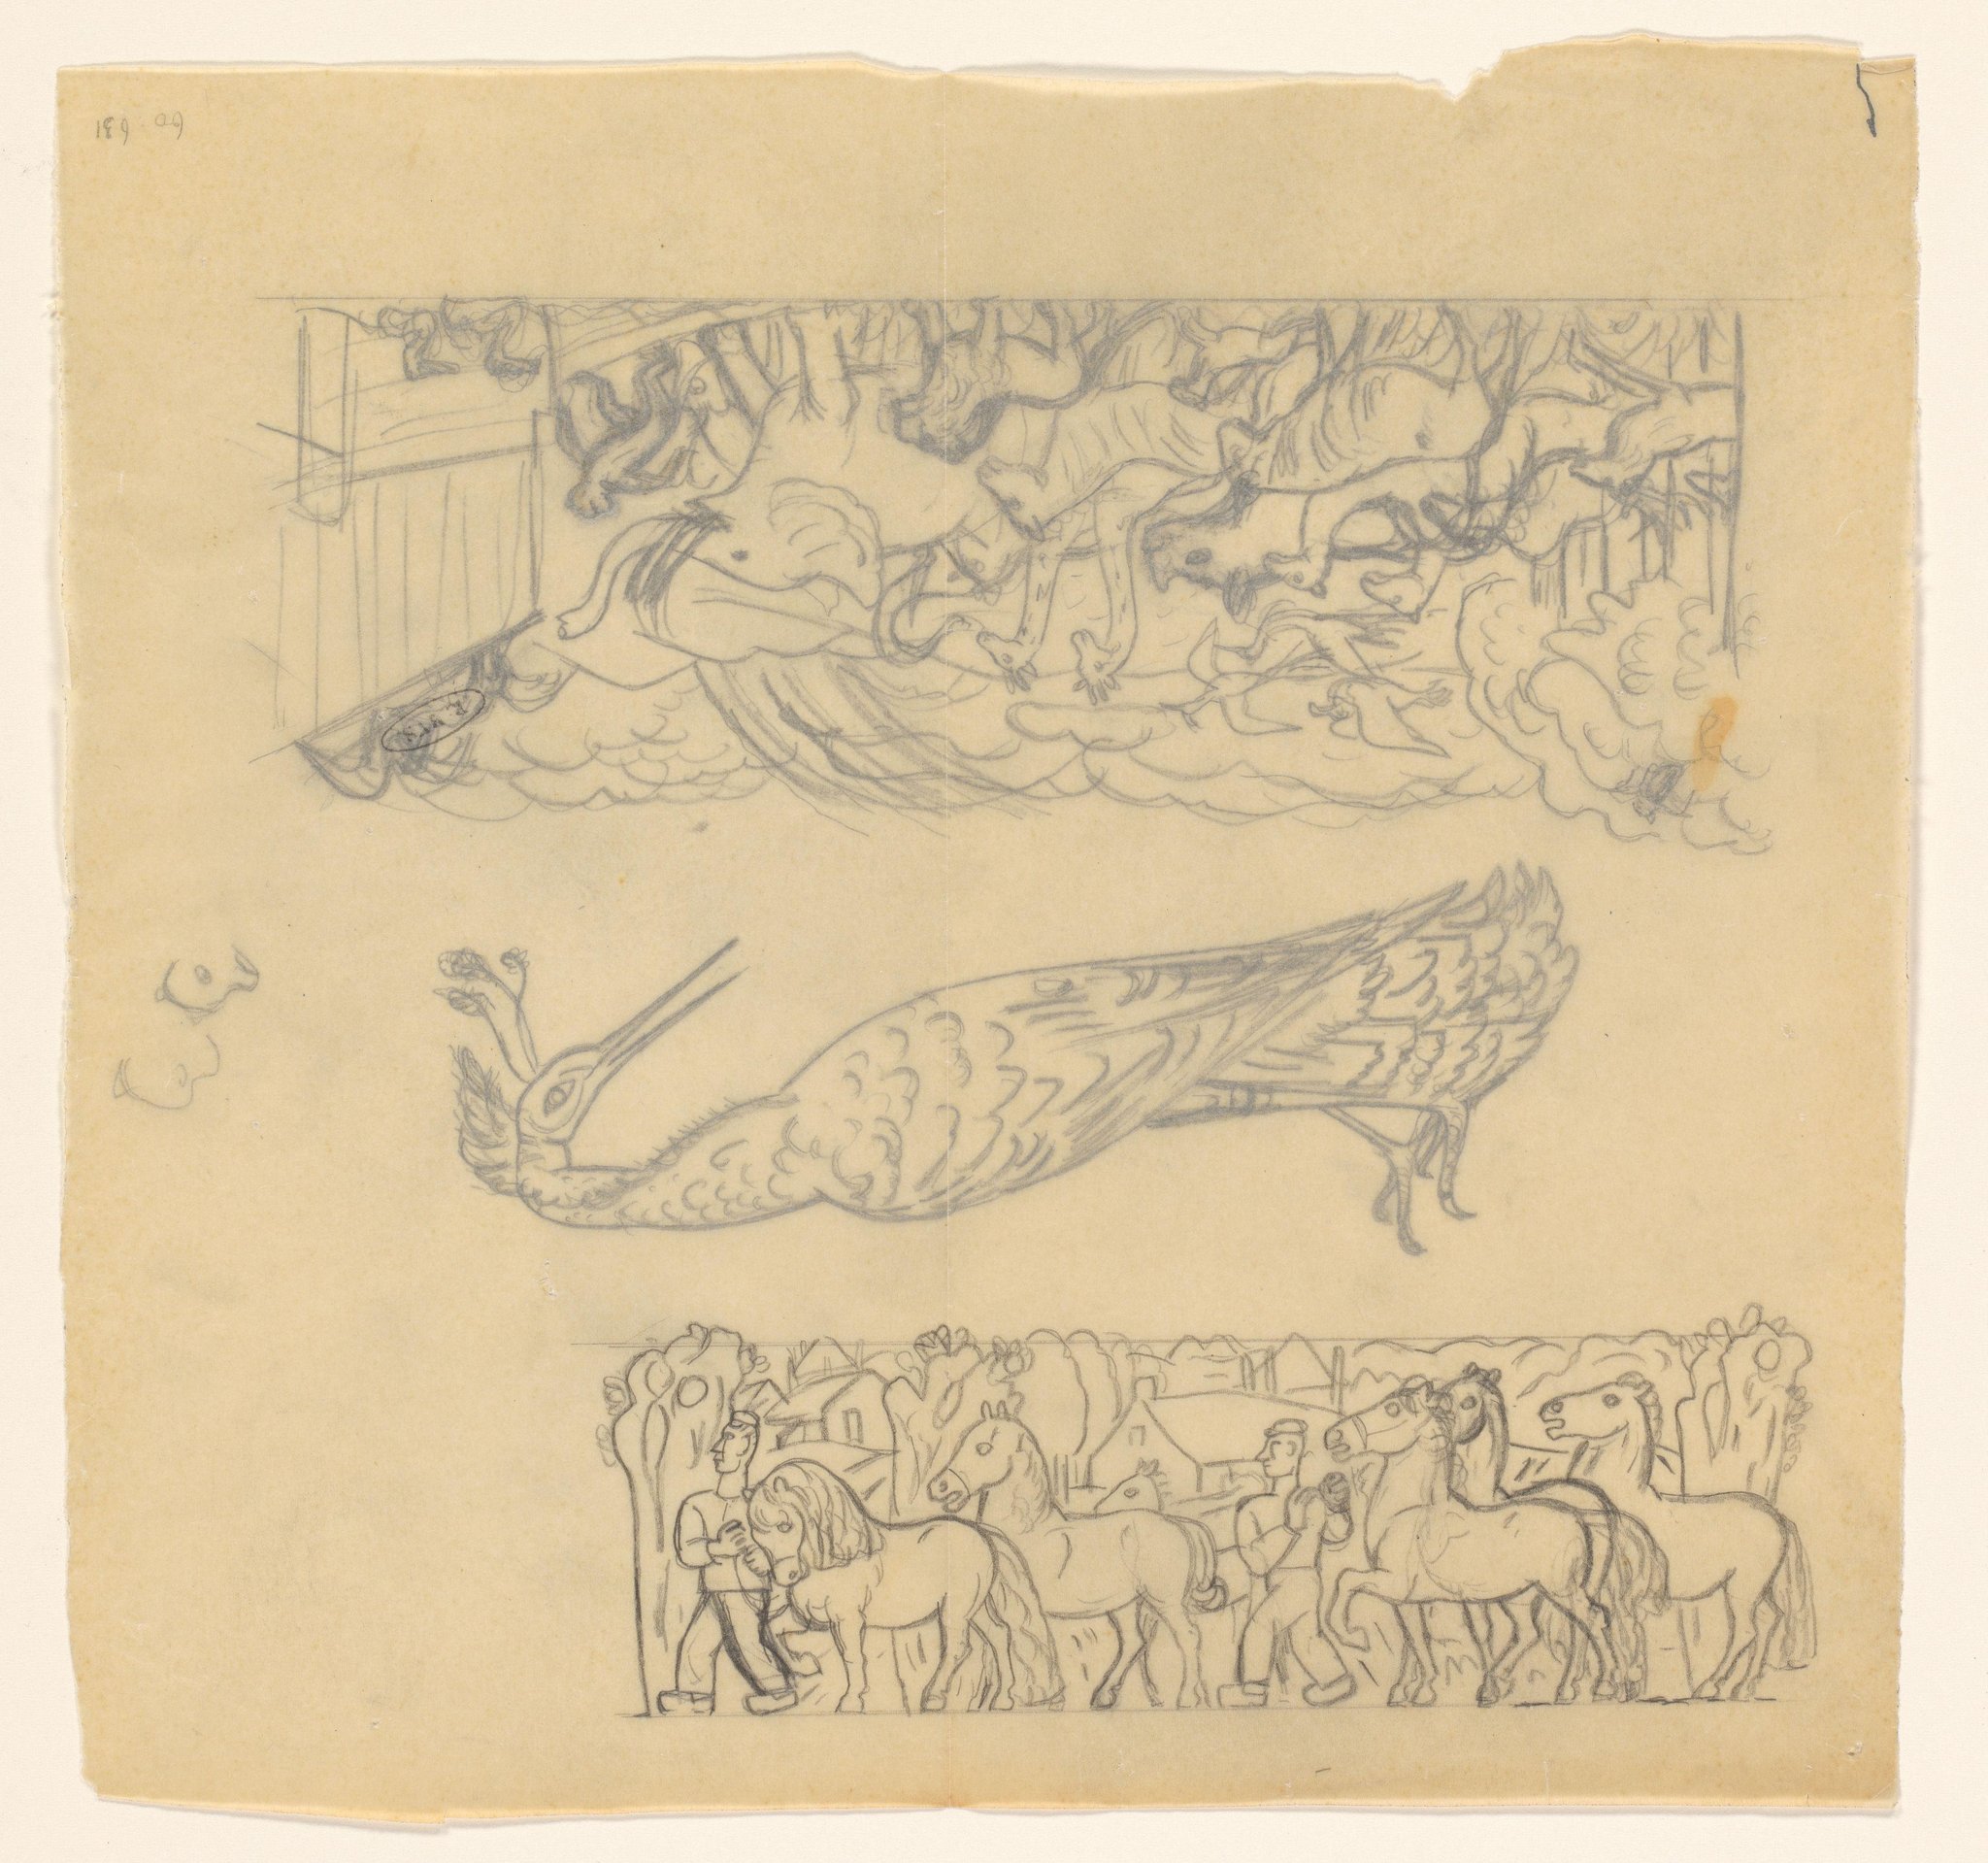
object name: drawing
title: Landschap met twee boeren, die paarden aan de hand leiden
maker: leo gestel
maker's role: draughtsman, print maker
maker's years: 1881-1941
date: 1891-1941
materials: pencil, paper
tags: farmers, horse, farm or solitary house in landscape